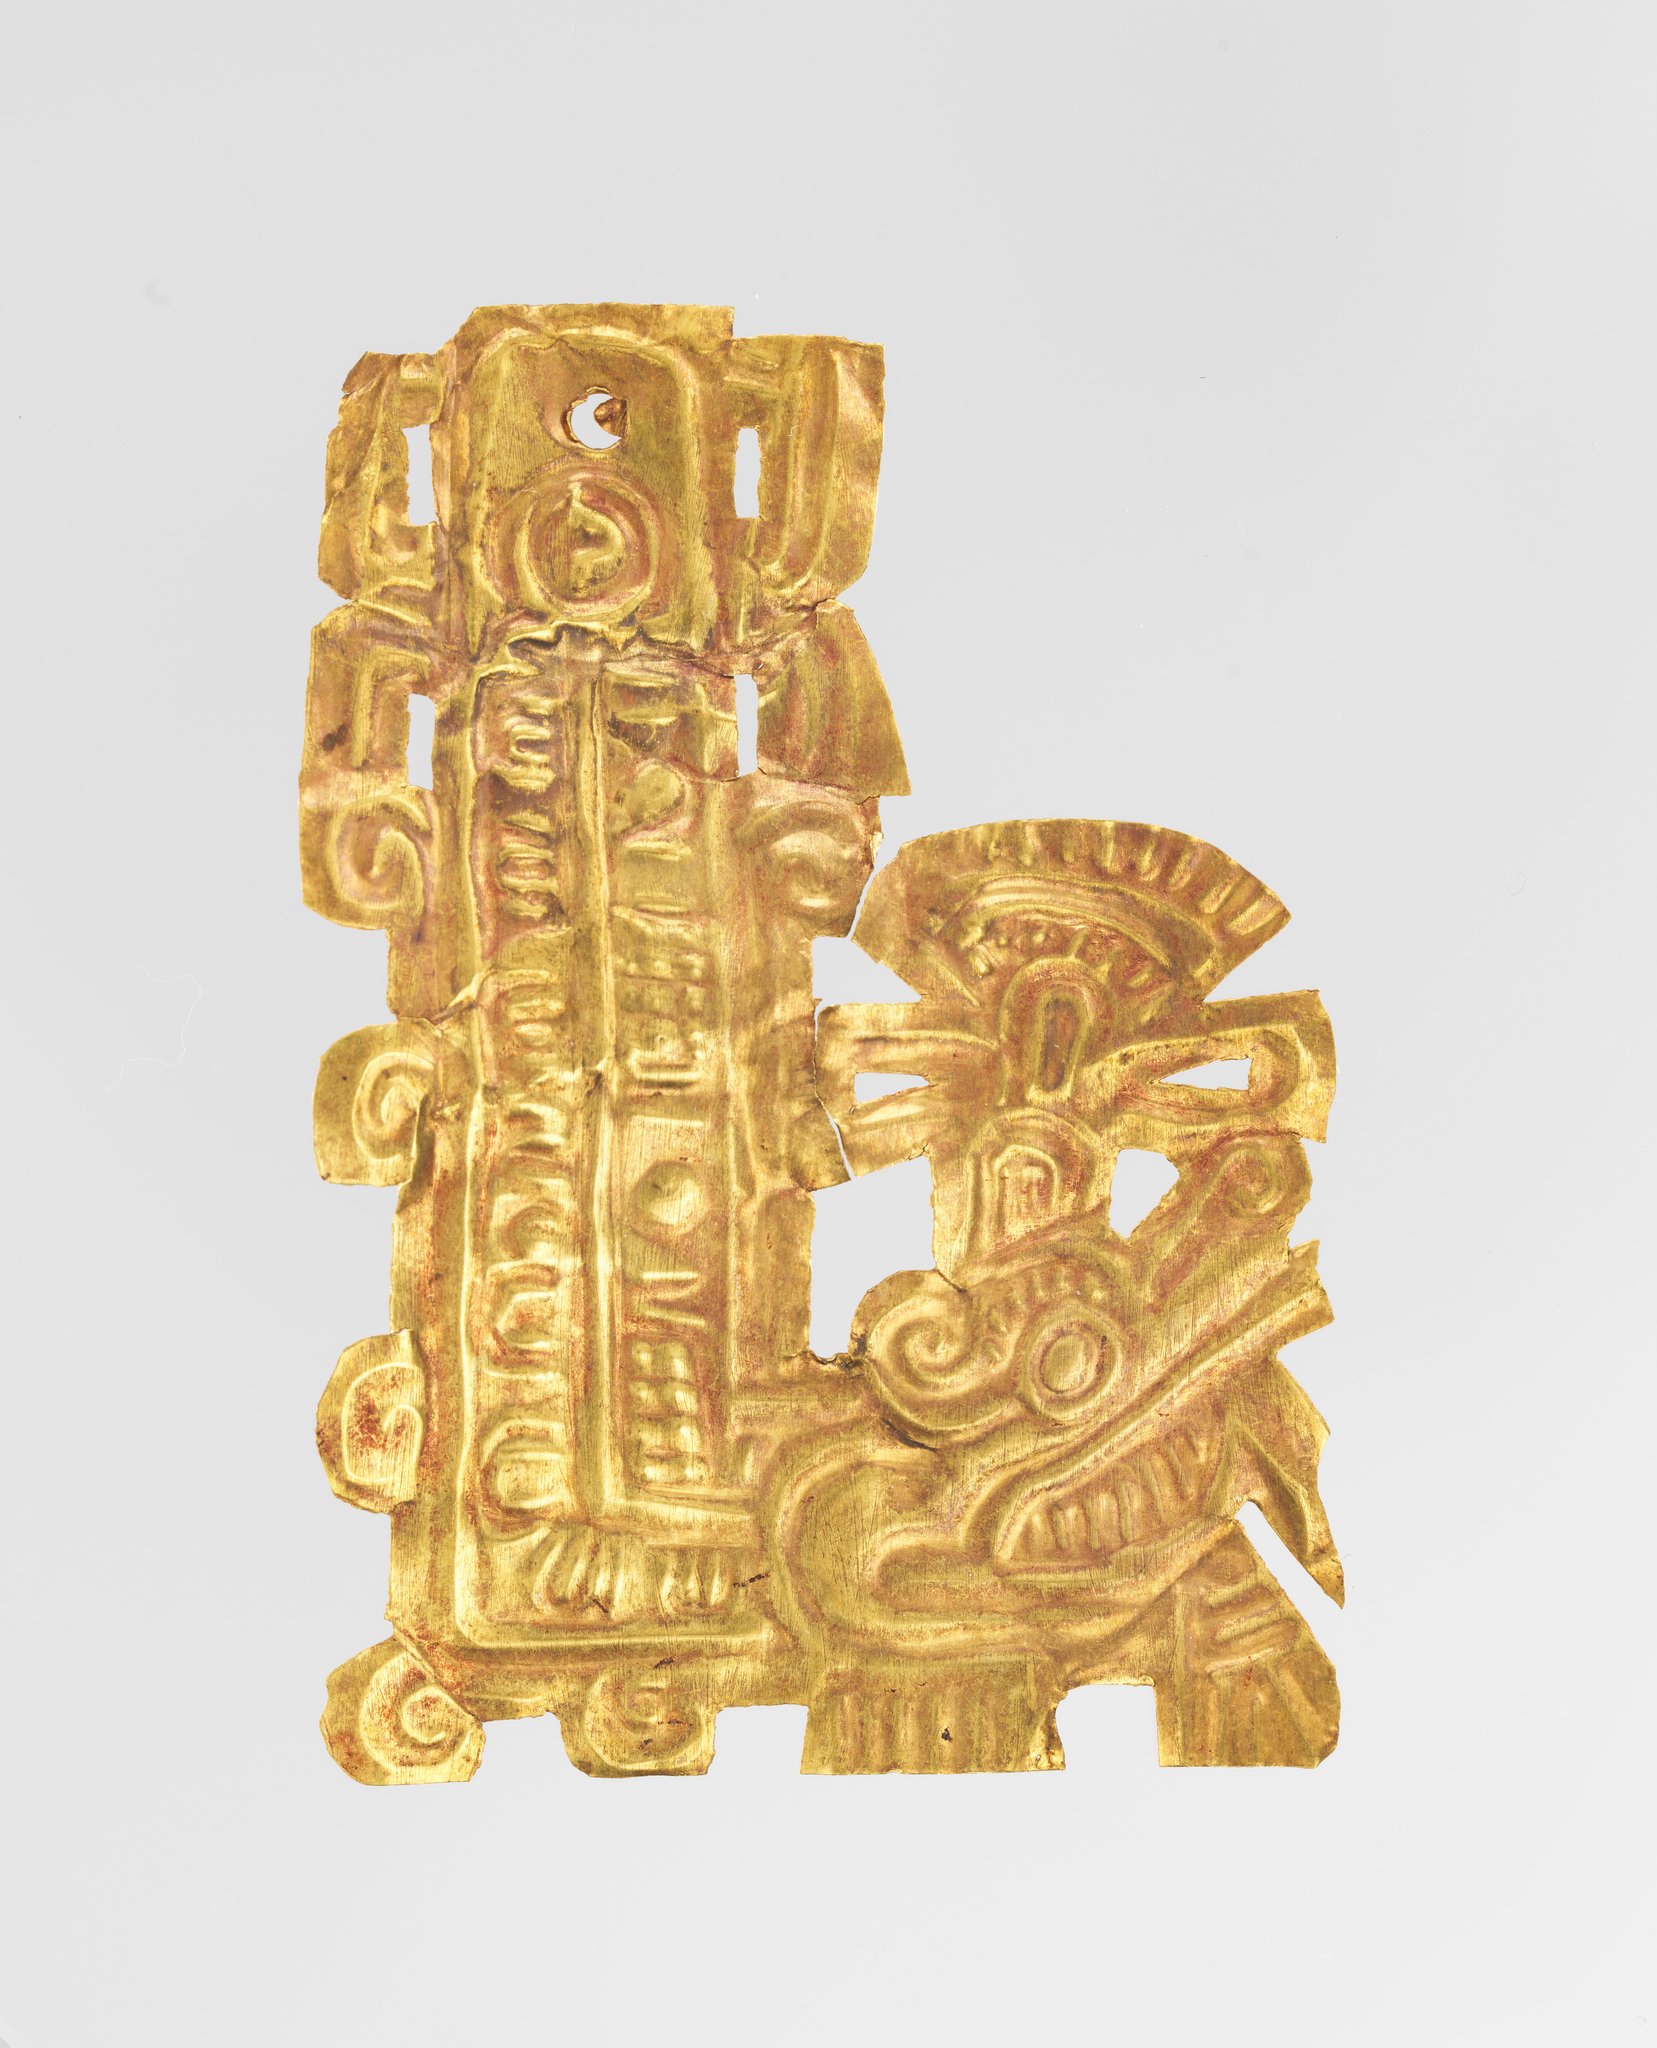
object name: ornament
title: Feathered serpent ornament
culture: mexica, aztec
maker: mexica or mixtec (ñuu savi) artists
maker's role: artist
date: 1325-1521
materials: gold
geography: mexico